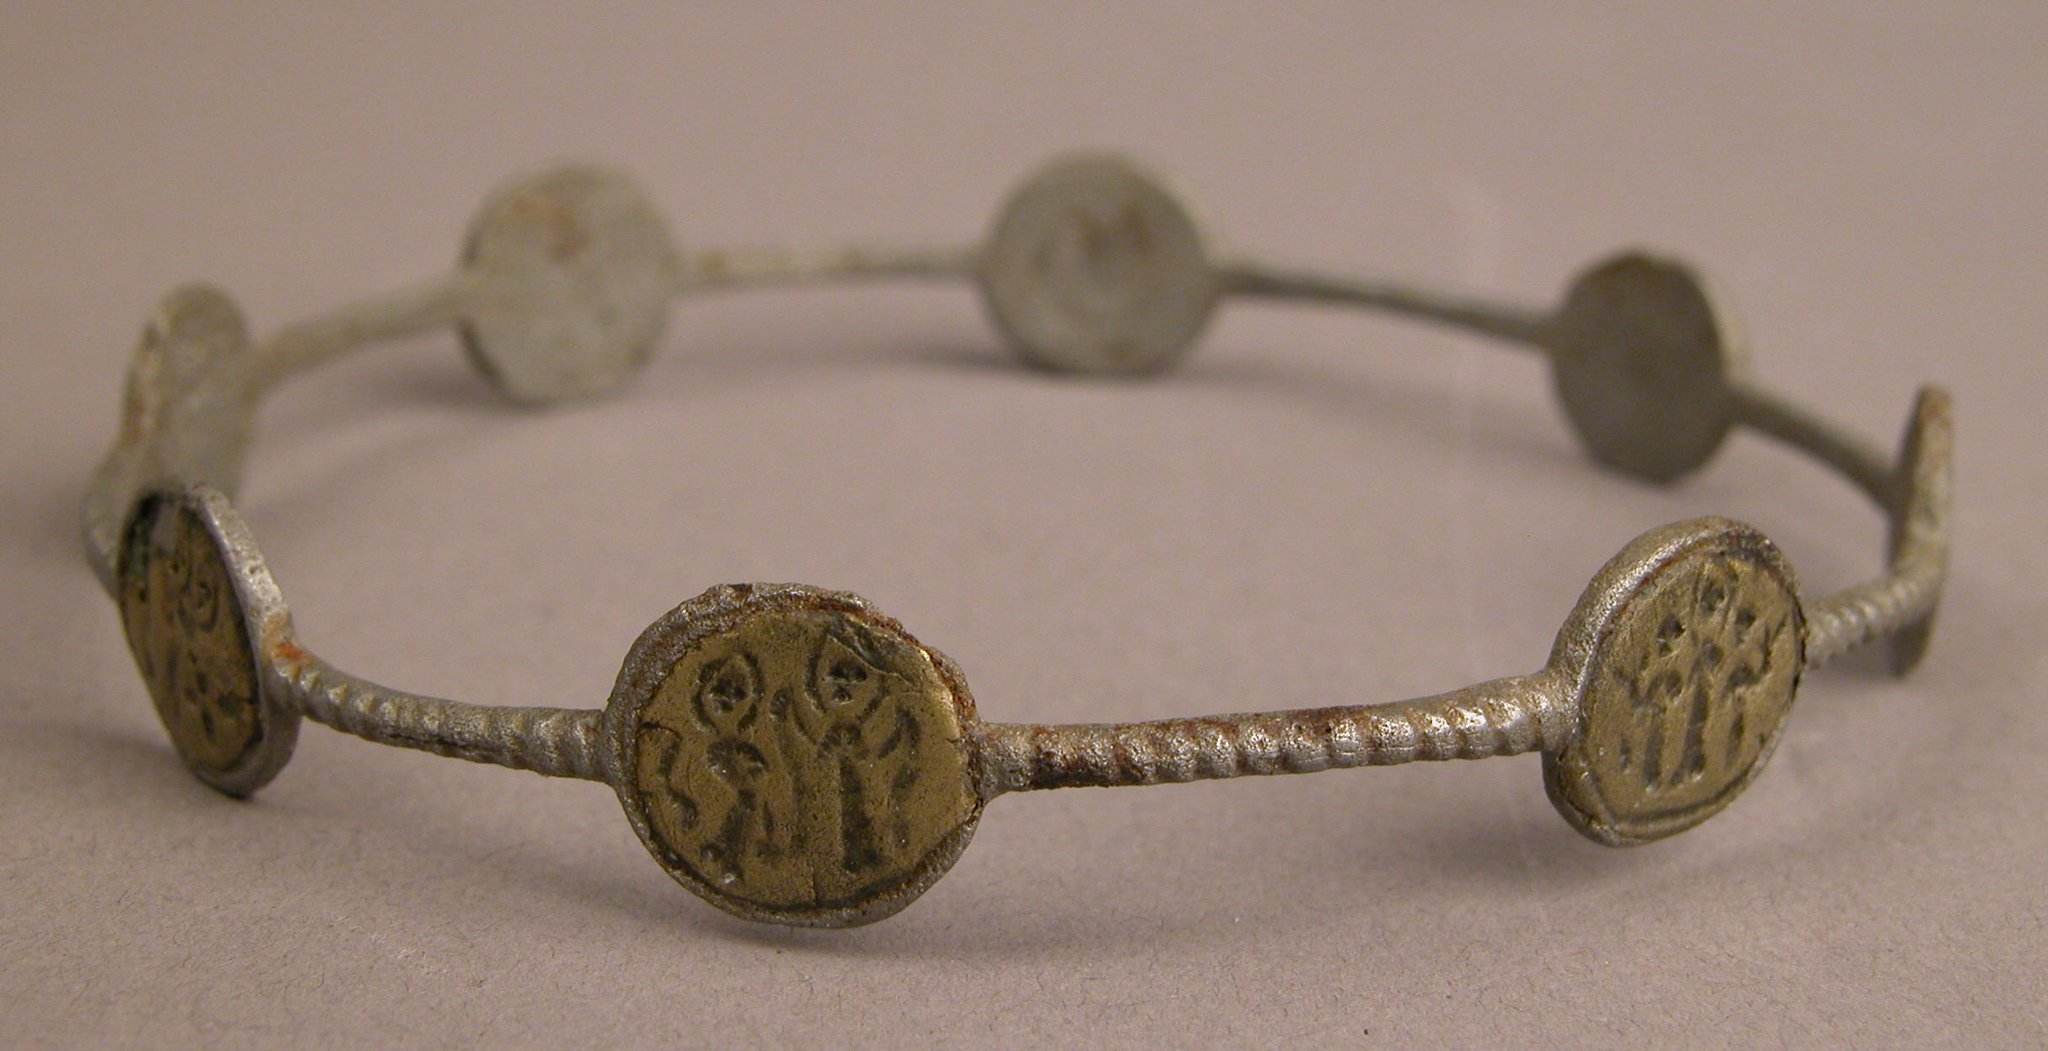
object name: bracelet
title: Bracelet with Holy Figures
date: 401-700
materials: copper, iron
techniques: inlay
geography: egypt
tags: medallions